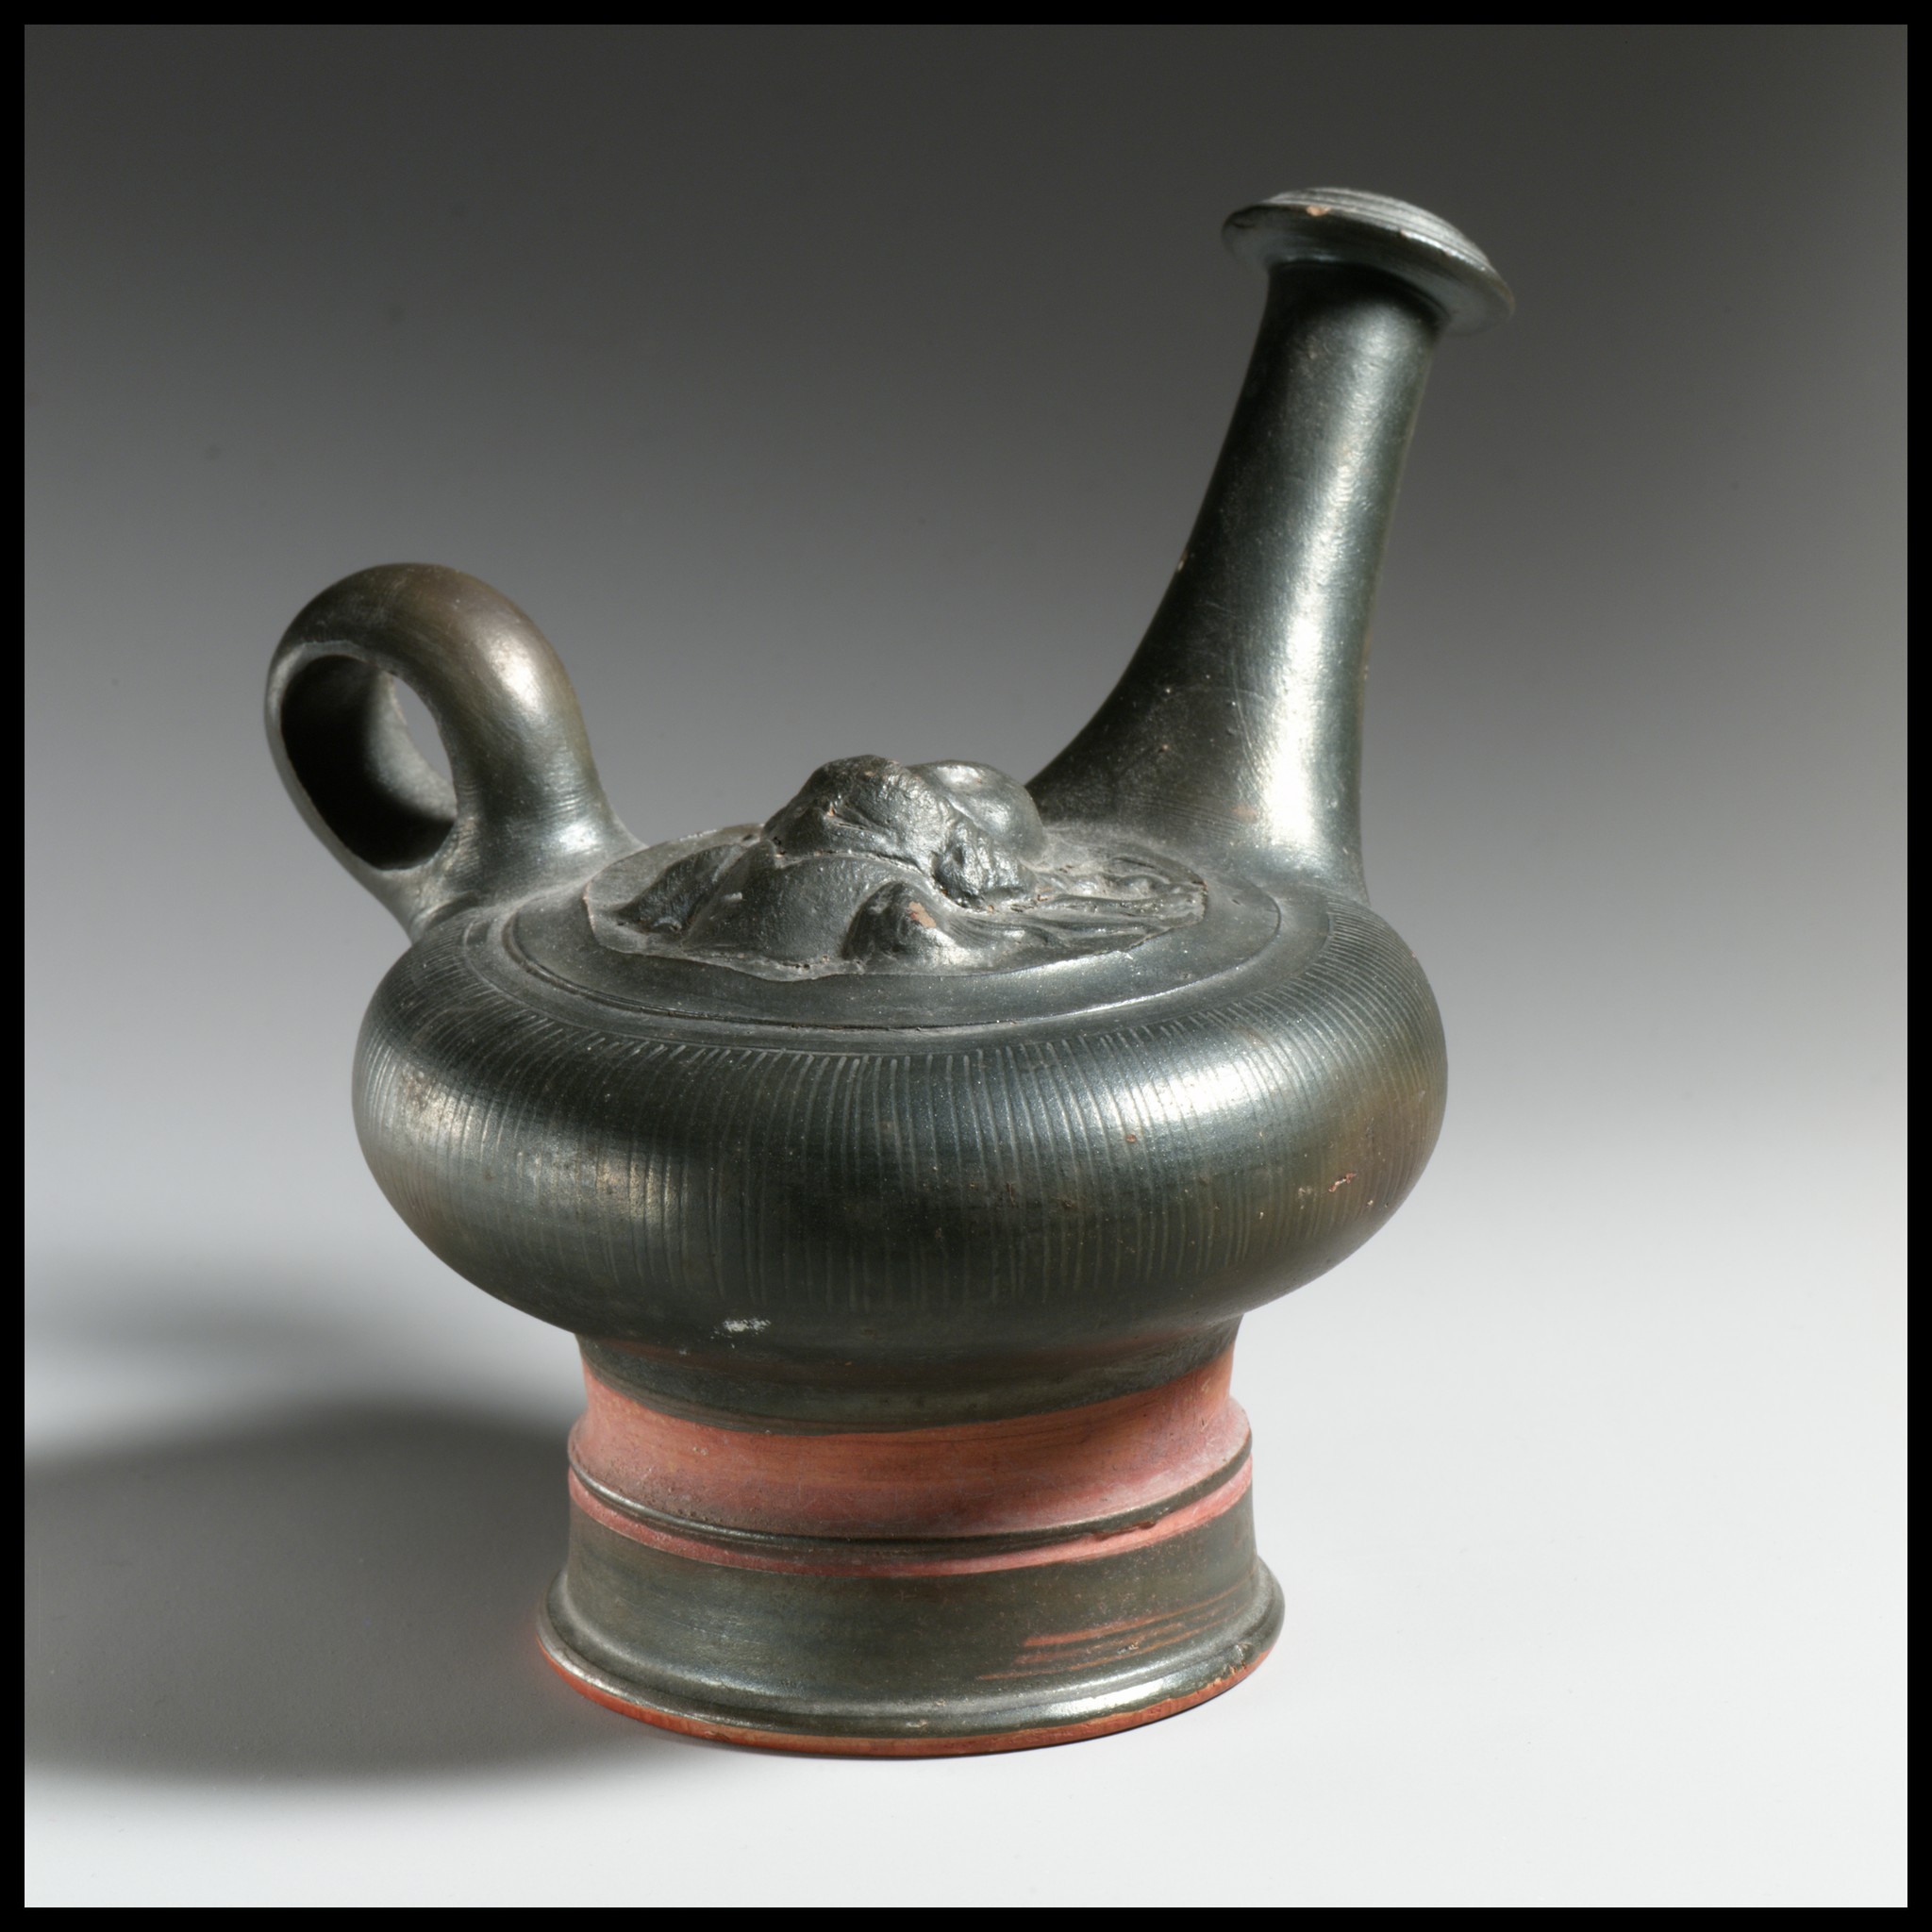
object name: guttus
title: Terracotta guttus (flask with handle and vertical spout)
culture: greek or south italian or campanian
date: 400-301 BCE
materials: terracotta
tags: athena